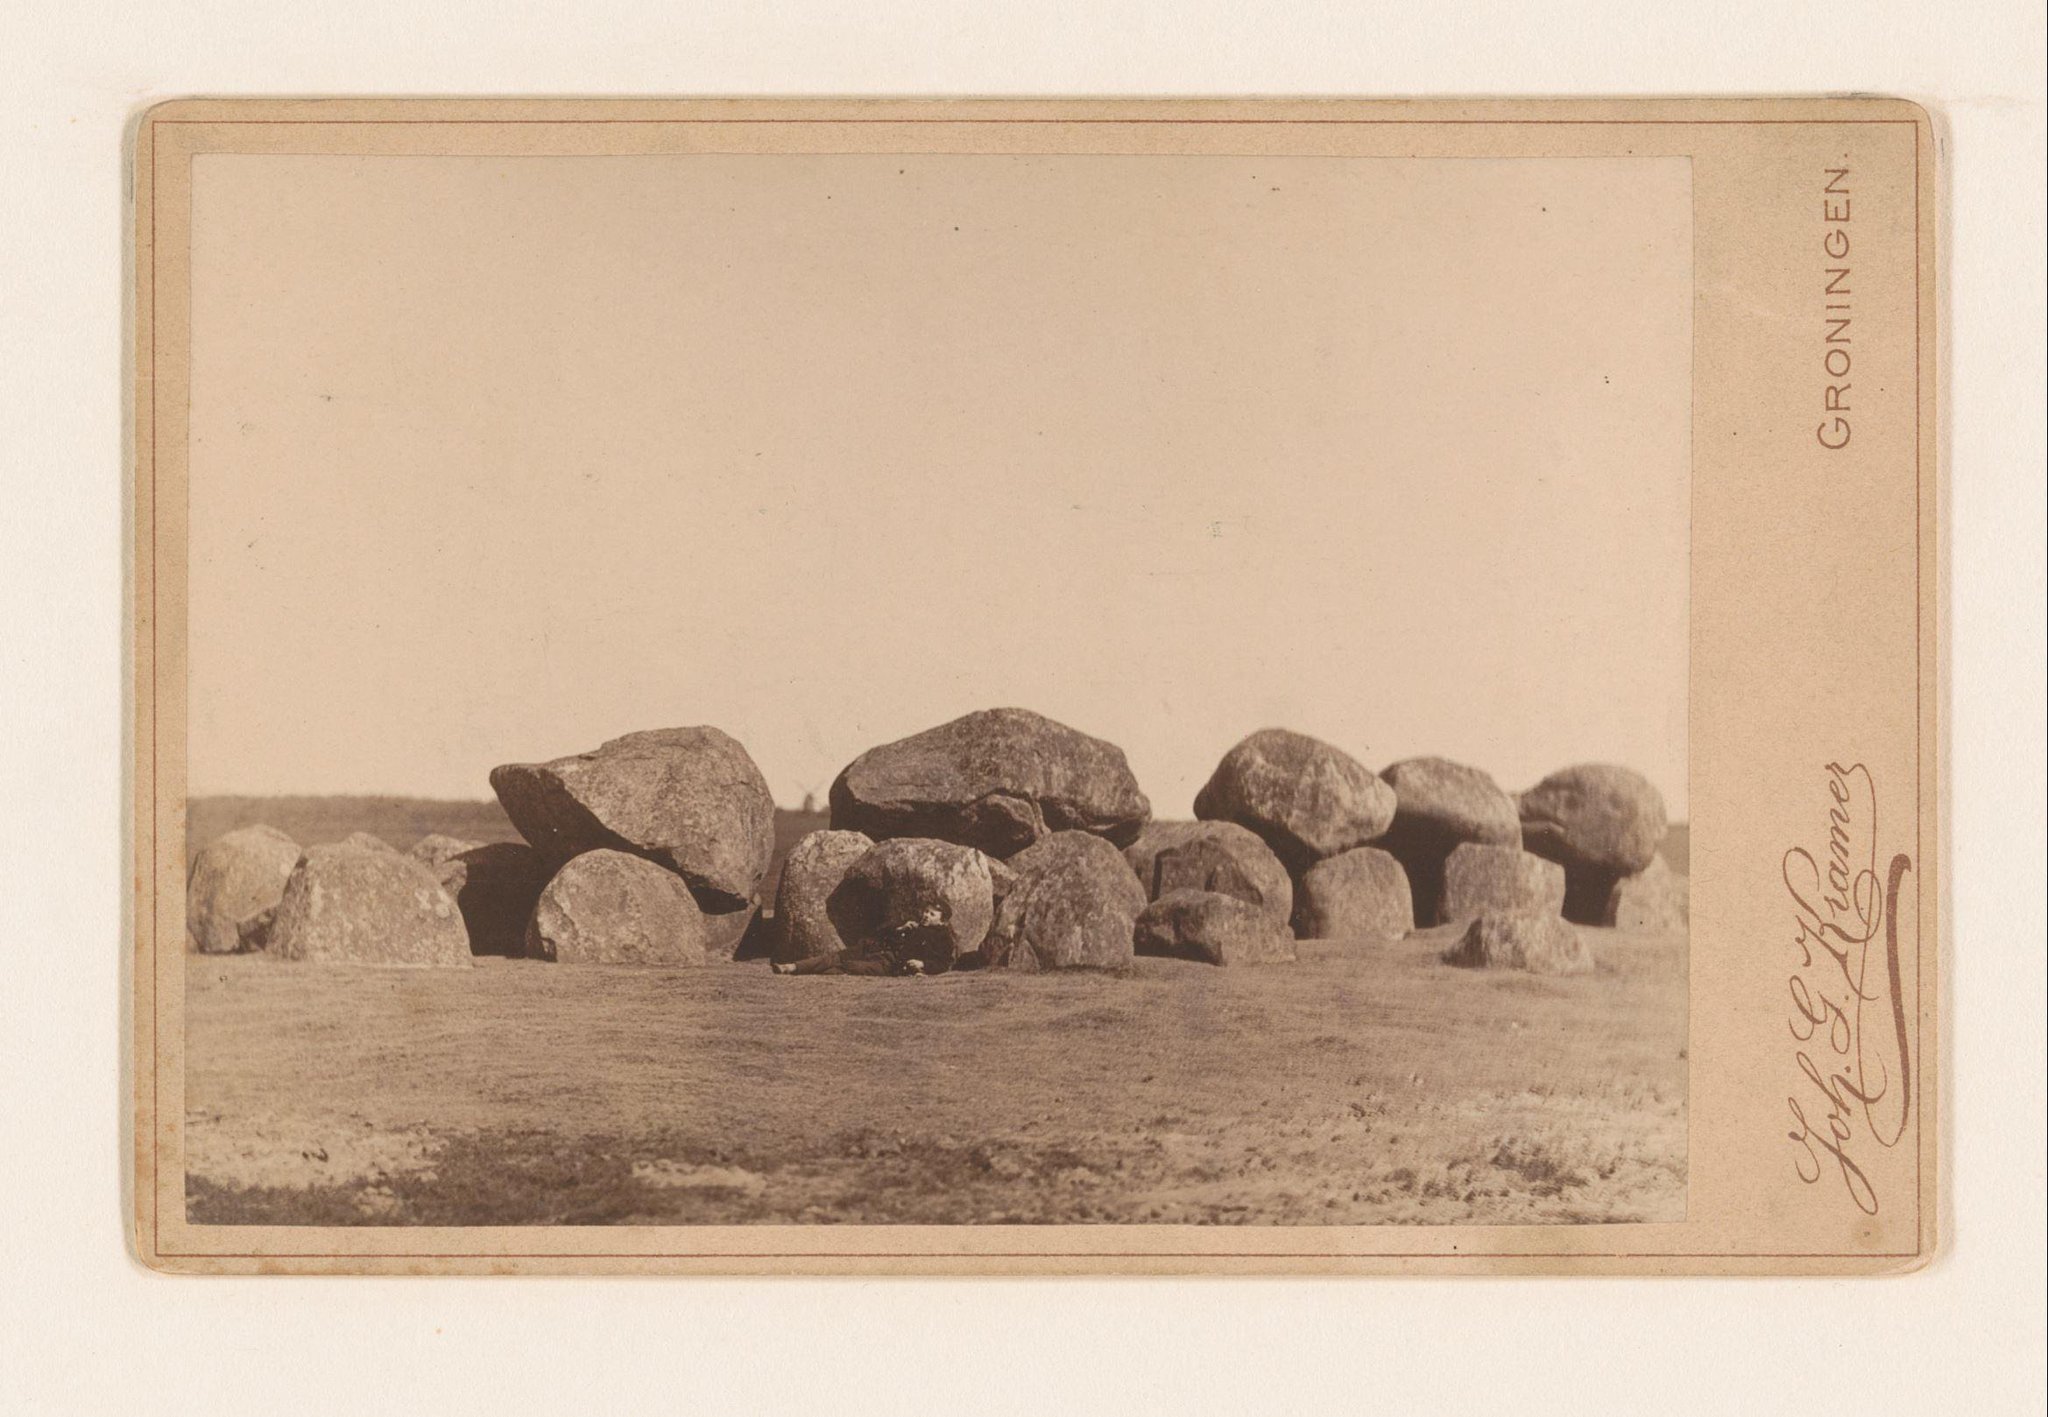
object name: cabinet photograph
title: Jongen, liggend bij een hunebed bij Eext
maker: johannes gerardus kramer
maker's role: fotograaf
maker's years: 1845-1903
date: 1878-1903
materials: cardboard, photographic support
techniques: albumen print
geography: gieten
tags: rock-formations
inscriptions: inscription: ‘Joh. G. Kramer/ Groningen/ Academieplein’, number: ‘22’, inscription: ‘Van Gorcum & Co/ A.D. Brink/ Assen’, annotation: ‘Gieten’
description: Jongen, liggend bij het hunebed D14 bij Eext.